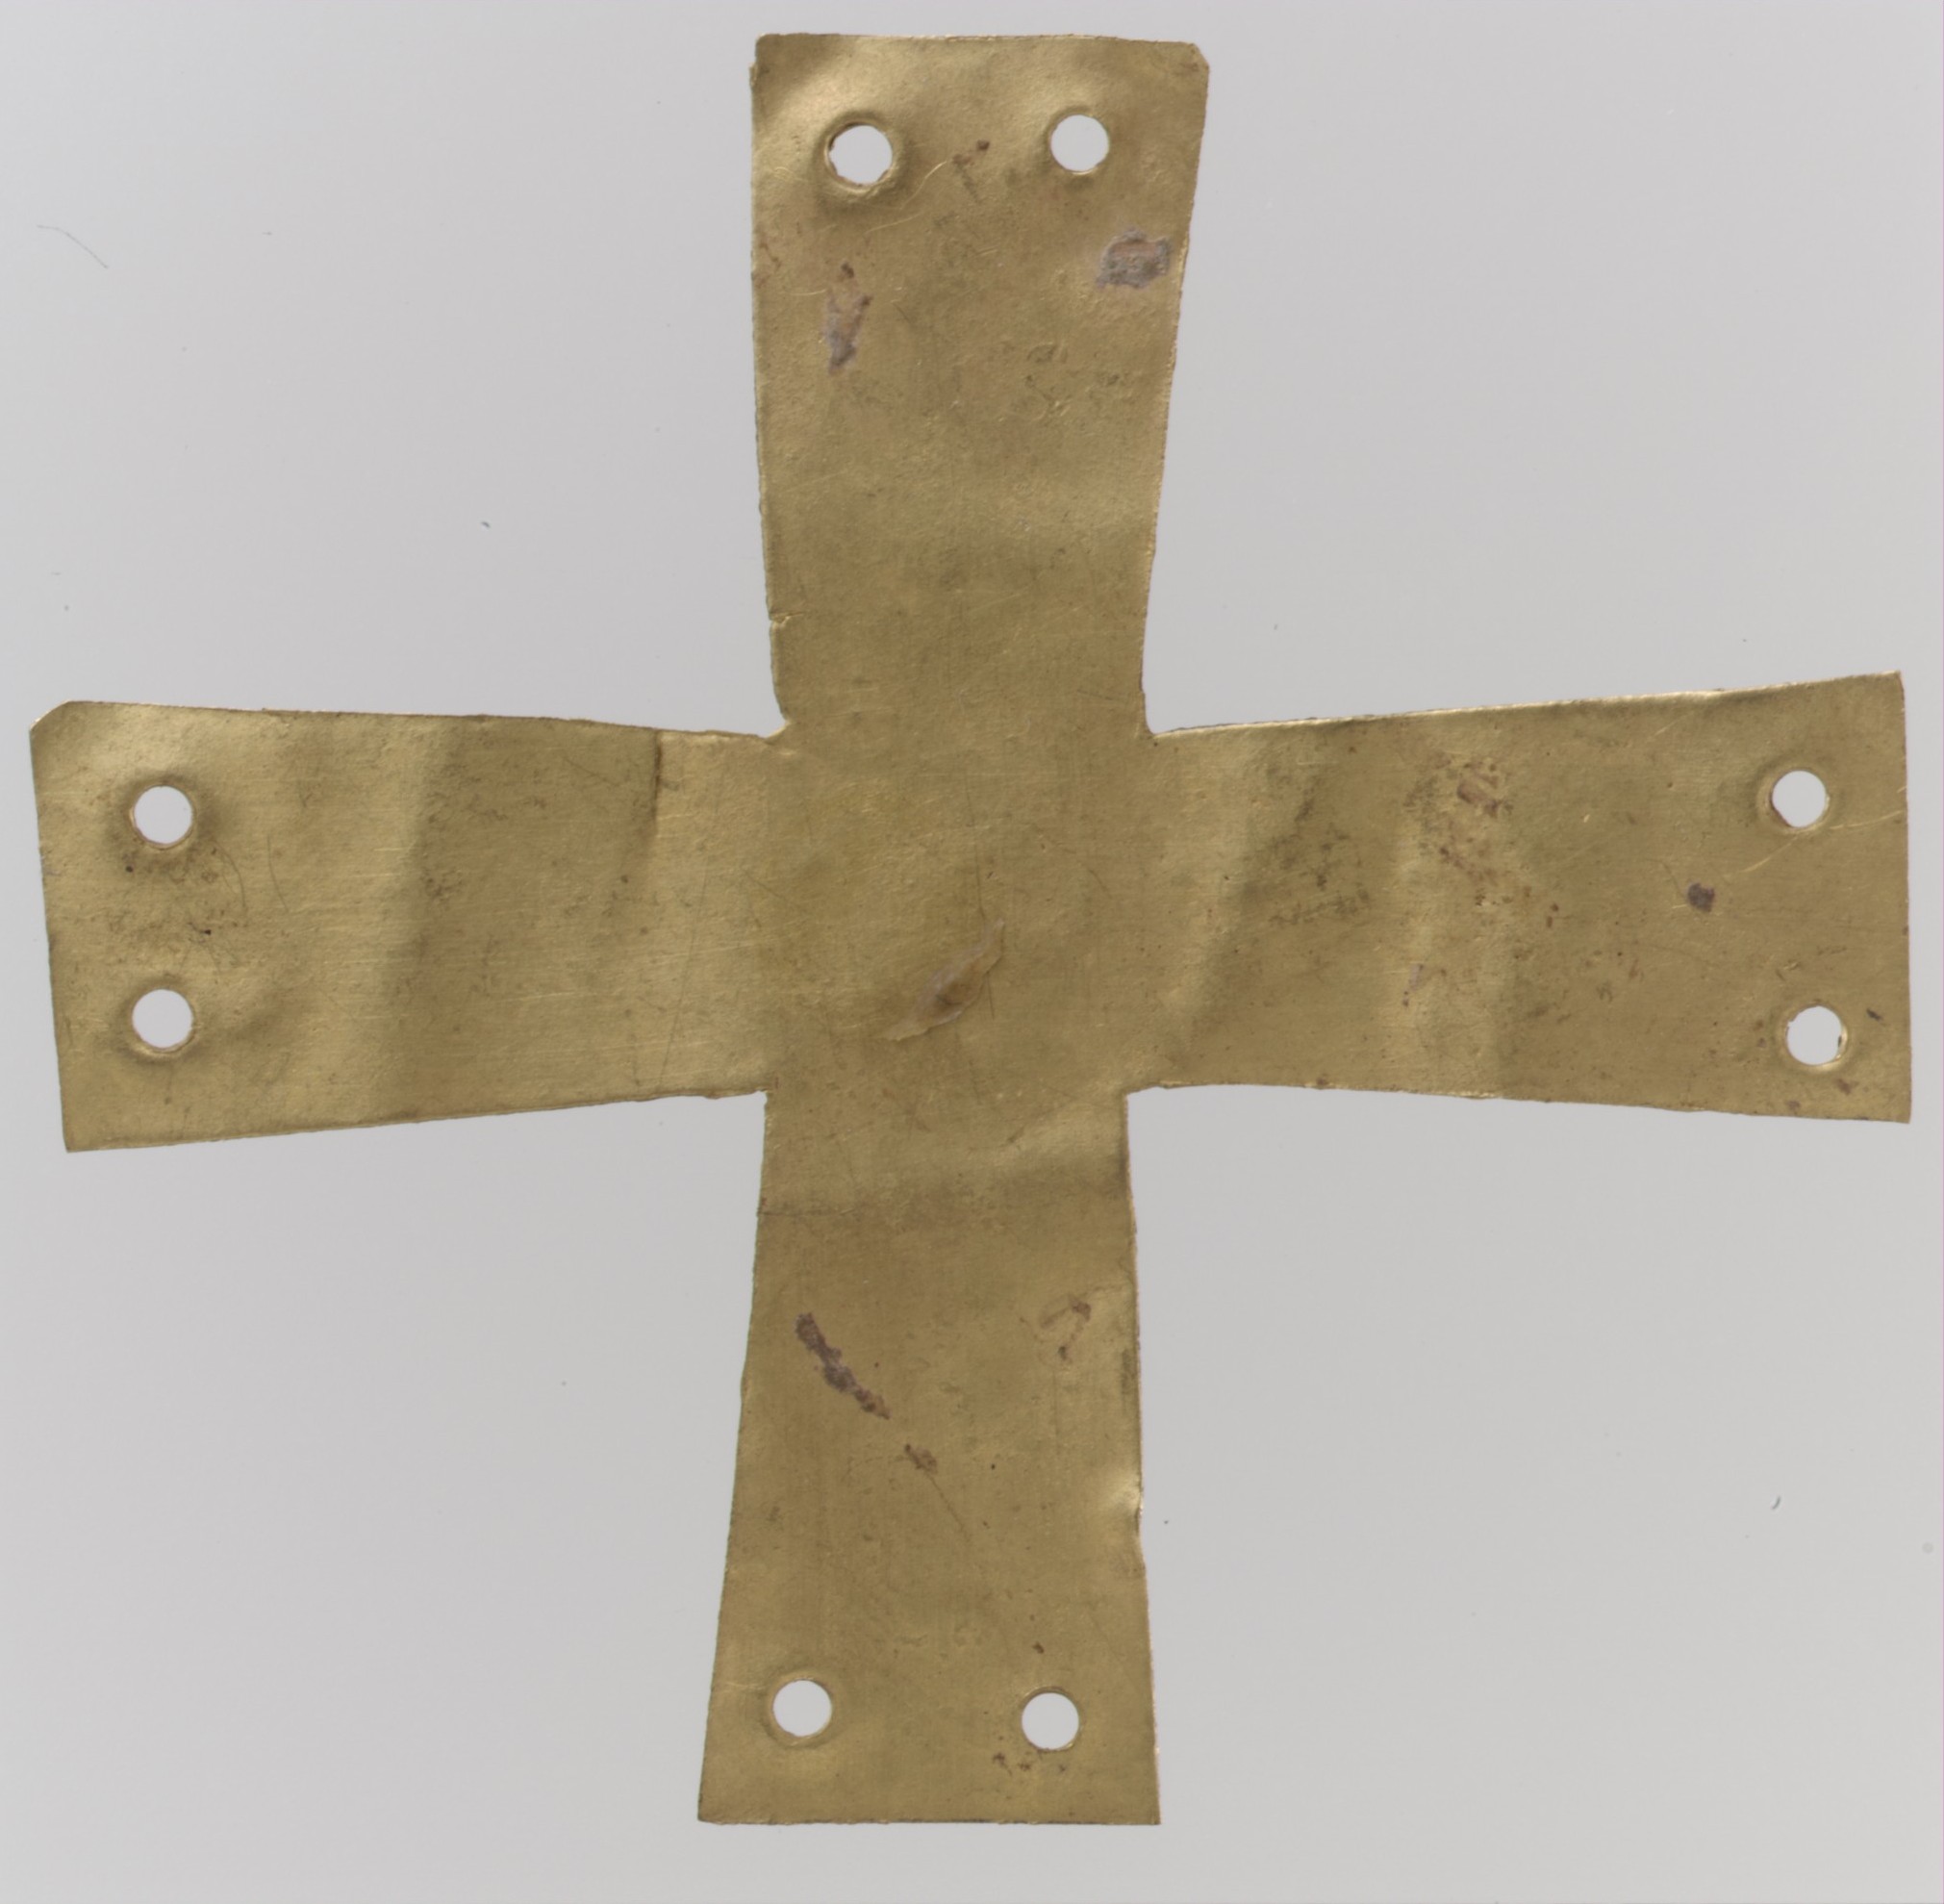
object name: appliqué cross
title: Gold Appliqué in the Form of a Cross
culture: langobardic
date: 600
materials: gold